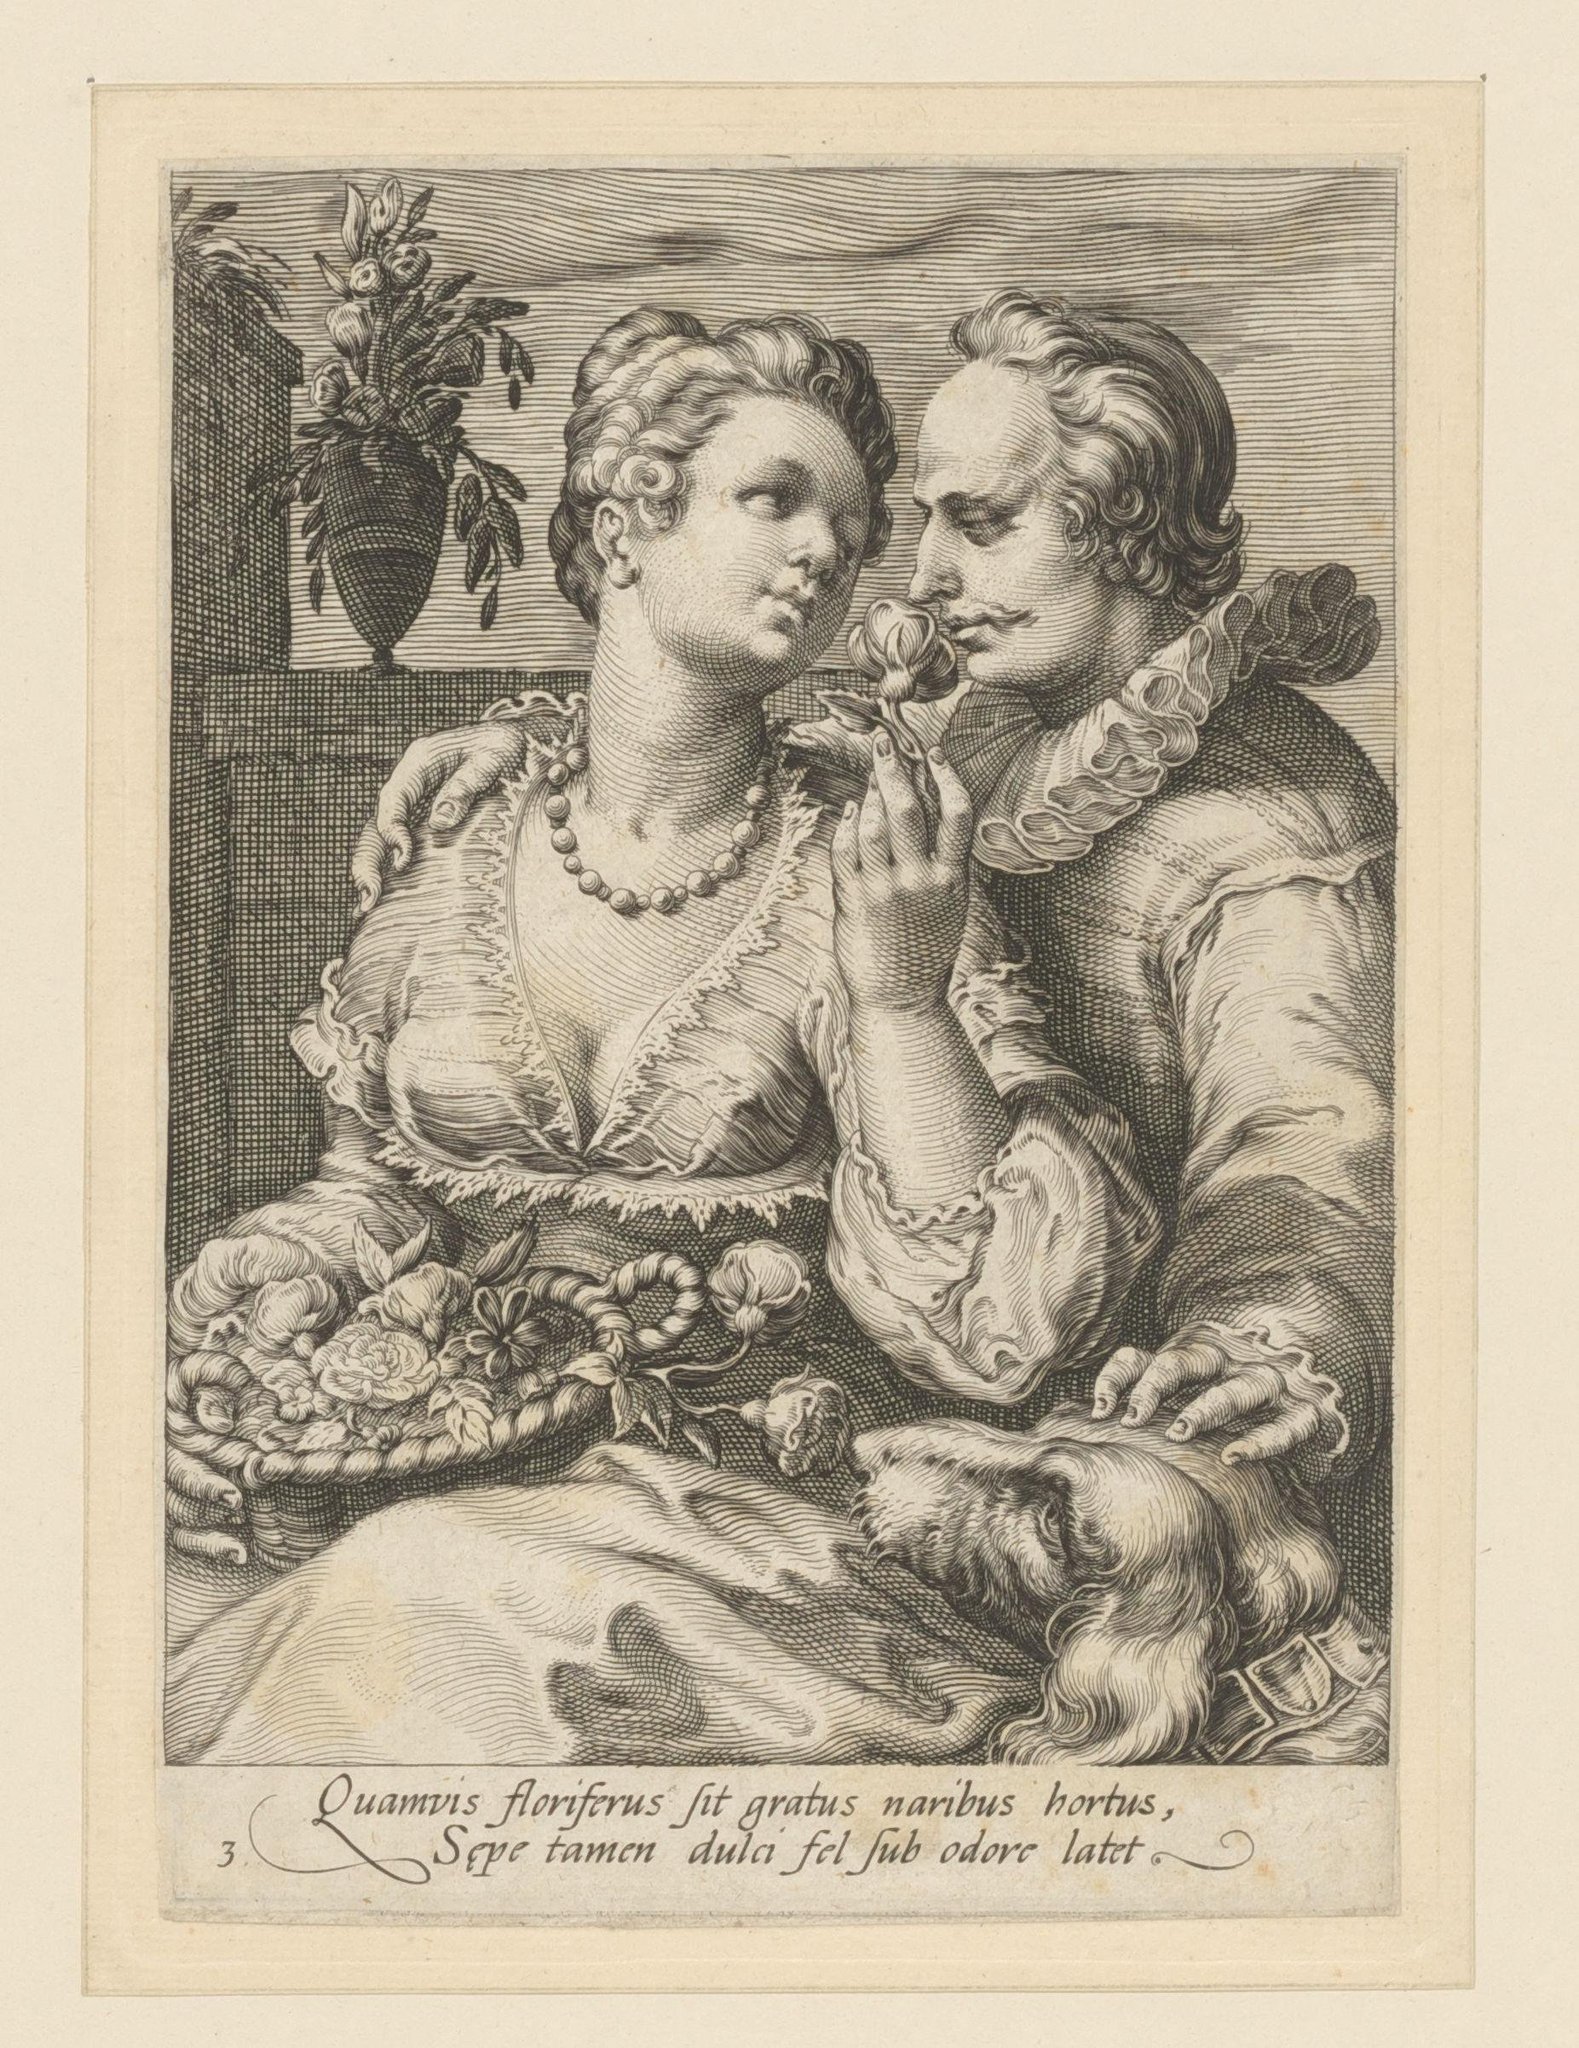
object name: print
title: De vijf zintuigen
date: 1575-1607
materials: paper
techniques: engraving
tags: smell, smelling (one of the five senses), dog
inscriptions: collector's mark: Lugt 1641, collector's mark: Lugt 963, check stamp: Lugt 1120, stamp:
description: De vrouwelijke personificatie van de Reuk laat de man die haar vergezelt een bloem ruiken. Bij haar schoot de kop van een hond. Onderwerpsrubrieken binnen de Atlas Zeden en Gewoonten: Zeden en Gewoonten in Engeren Zin, De Kleeding, Kleederdrachten (tijdvakken), Het begin der 17de eeuw. (De Fransche mode).